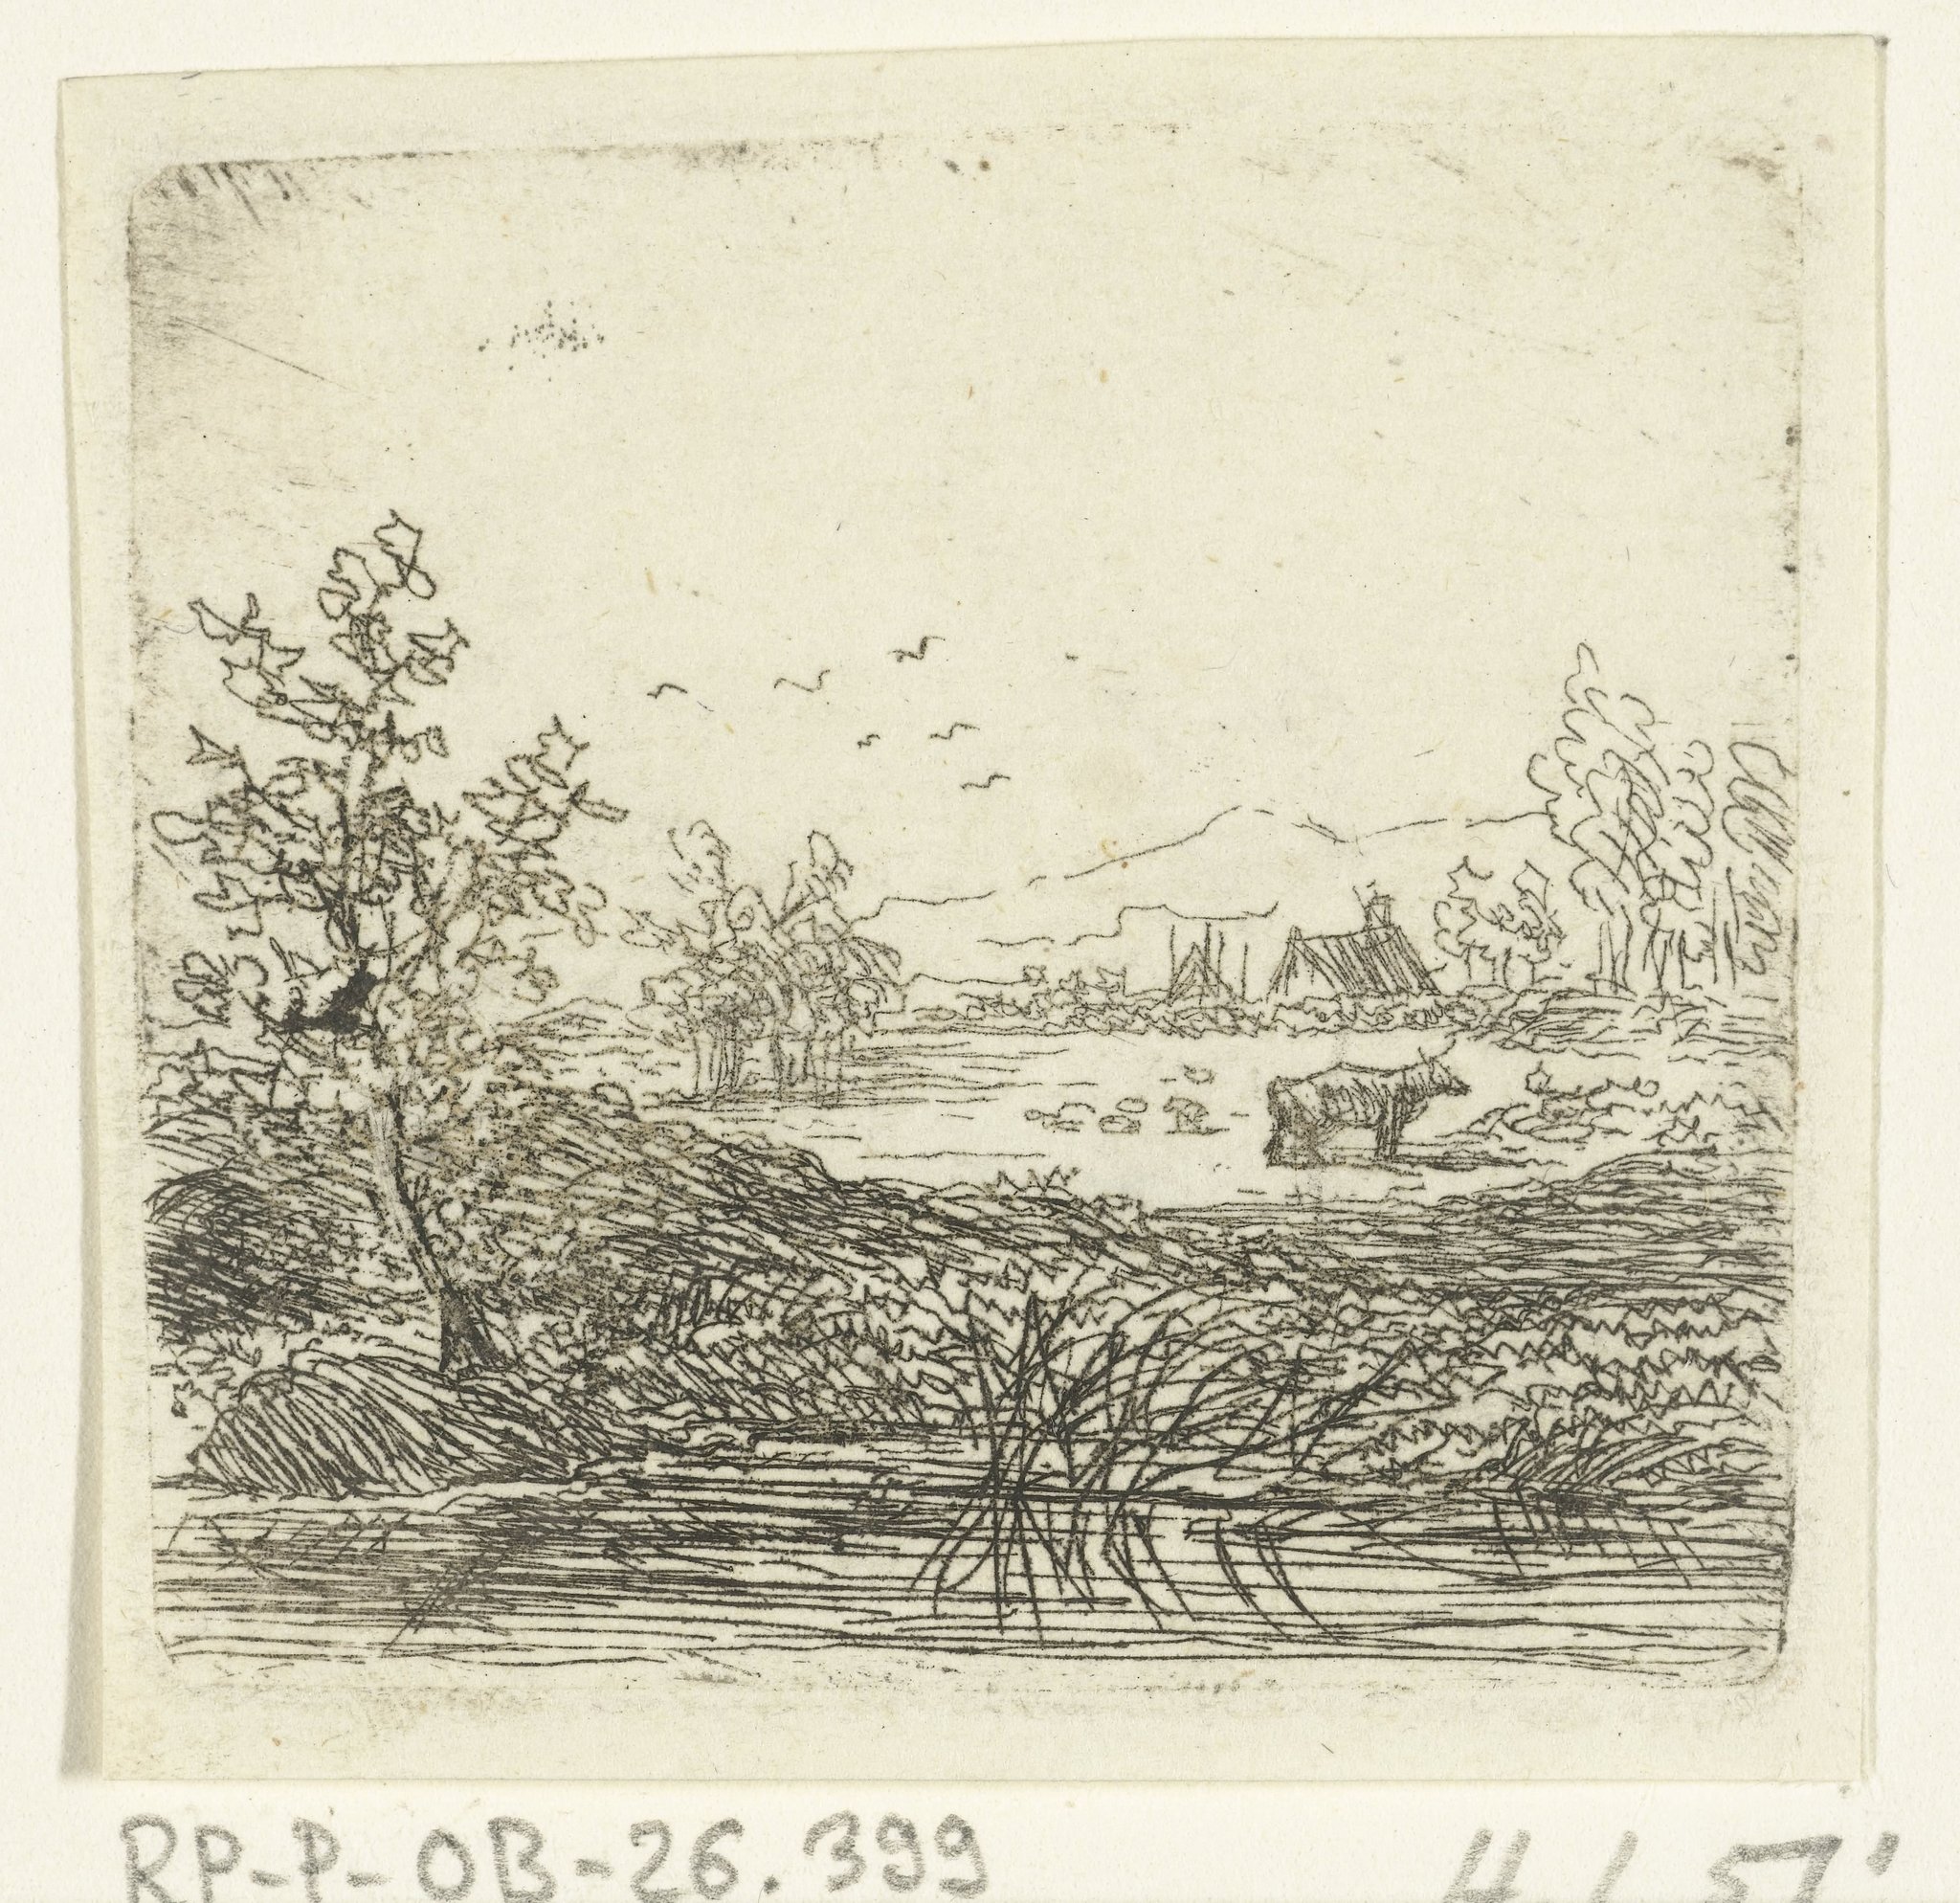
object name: print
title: Waterlandschap met koe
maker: ernst willem jan bagelaar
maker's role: draughtsman, print maker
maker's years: 1775-1837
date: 1798-1837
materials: paper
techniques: etching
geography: netherlands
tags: landscapes with waters, waterscapes, seascapes (in the temperate zone)